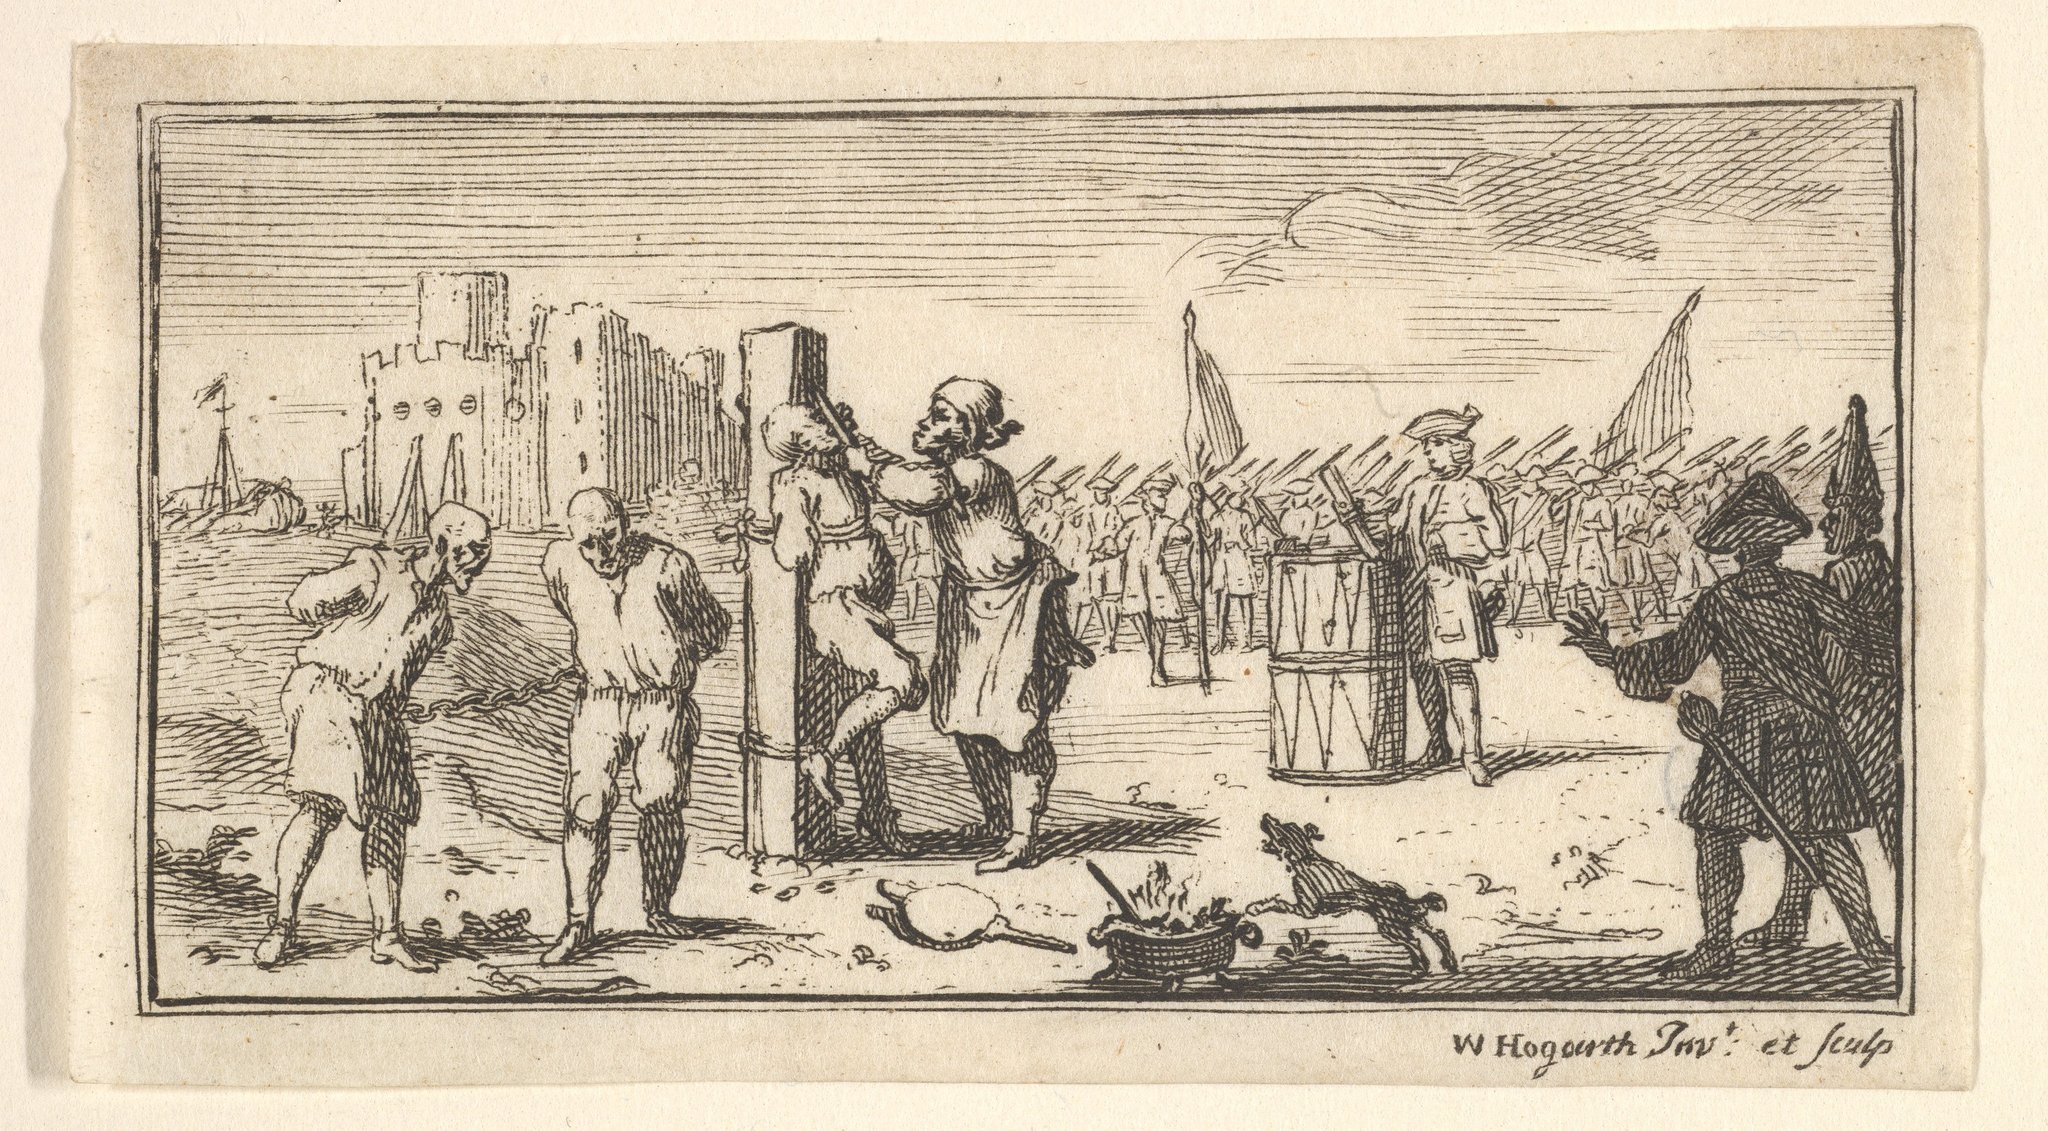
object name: print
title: Cutting Off the Nose (Modern Military Punishments)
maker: william hogarth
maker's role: artist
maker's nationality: british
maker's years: 1697-1764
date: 1725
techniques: etching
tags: castles,military,knives,men,drums,dogs,flags,punishment